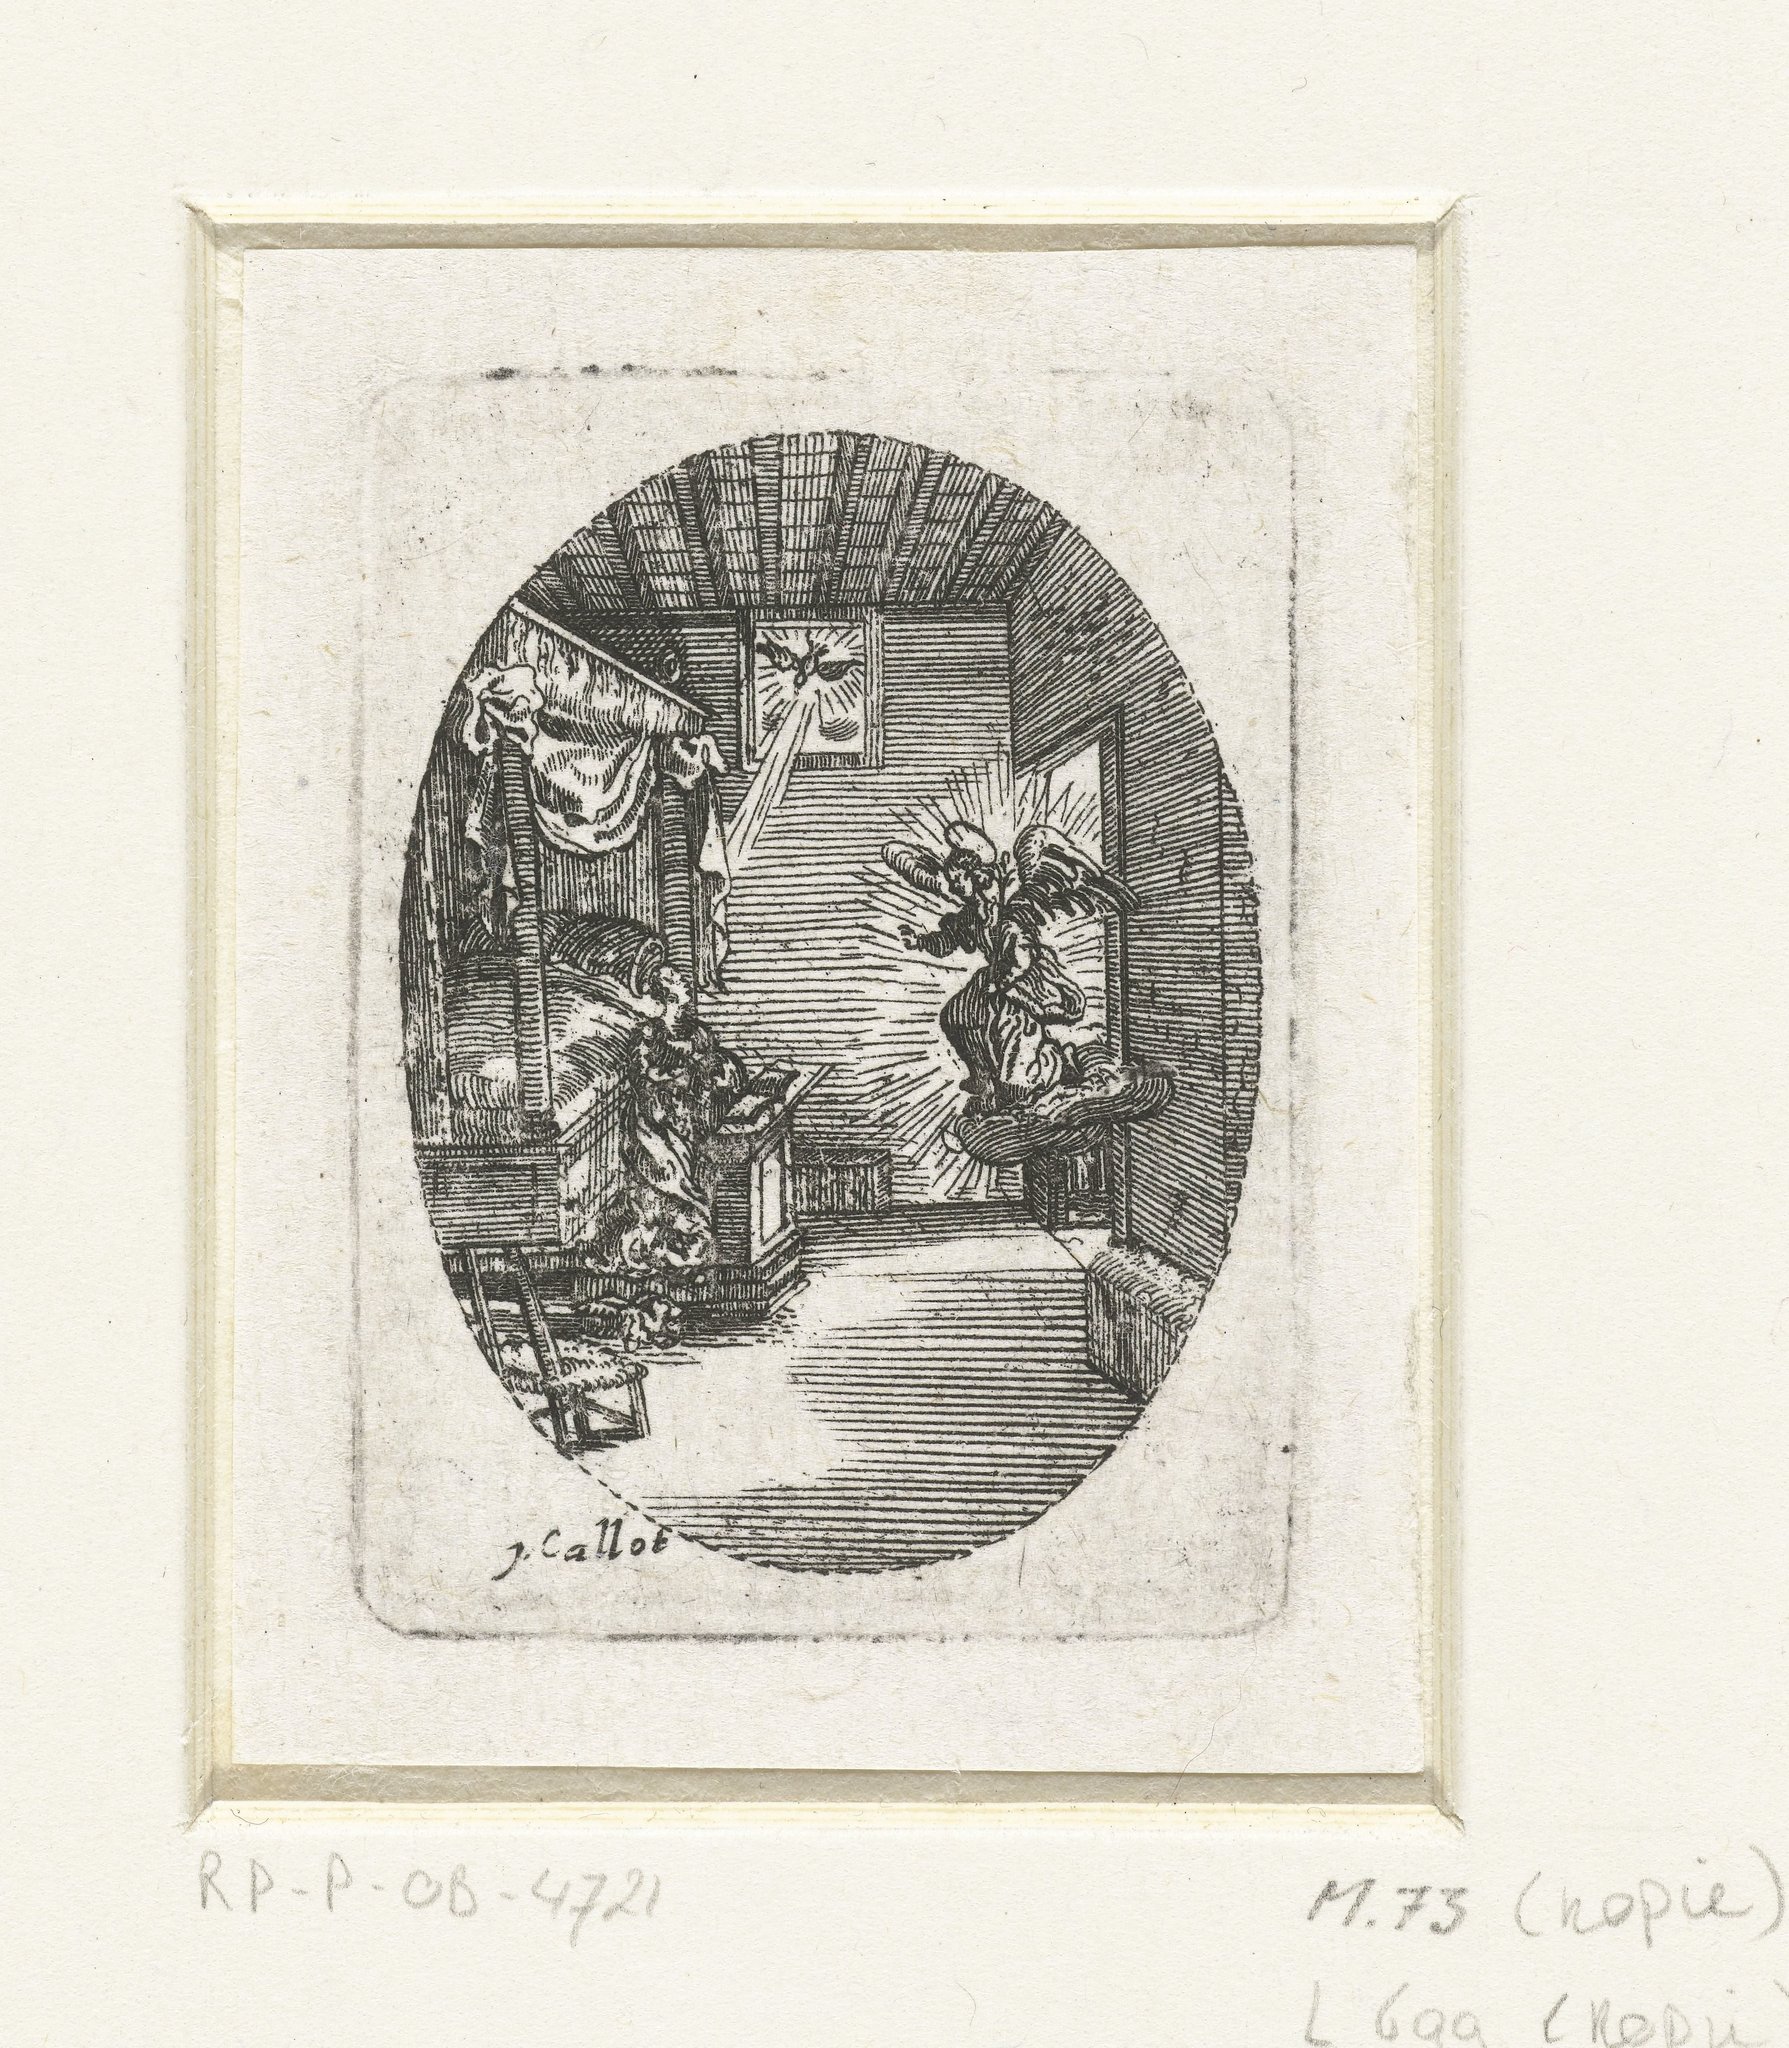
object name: print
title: Annunciatie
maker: jacques callot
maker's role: draughtsman, print maker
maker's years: 1592-1635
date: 1631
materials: paper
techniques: engraving, etching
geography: nancy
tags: the annunciation: mary kneeling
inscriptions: collector's mark: Lugt 240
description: Ovale voorstelling van een engel die aan Maria, die voor haar bed achter een lezenaar zit, de geboorte van Christus voorspelt. Bovenin de Heilige Geest in de gedaante van een duif.